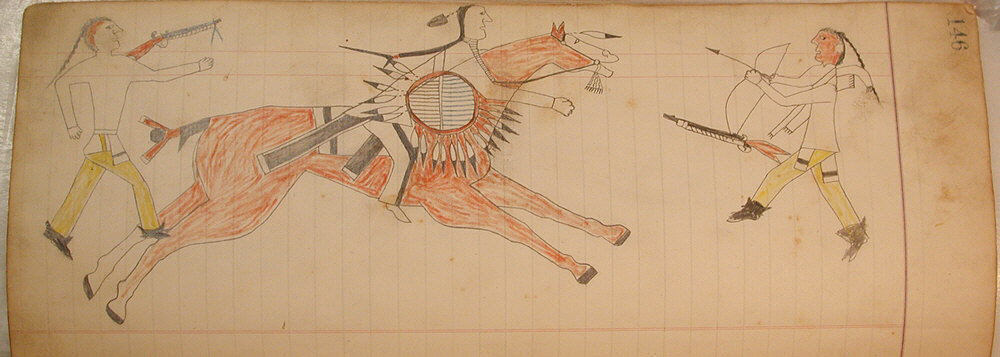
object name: drawing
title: Maffet Ledger: Drawing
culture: cheyenne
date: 1874-1881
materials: crayon, graphite, paper, watercolor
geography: united states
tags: weapons,men,horses